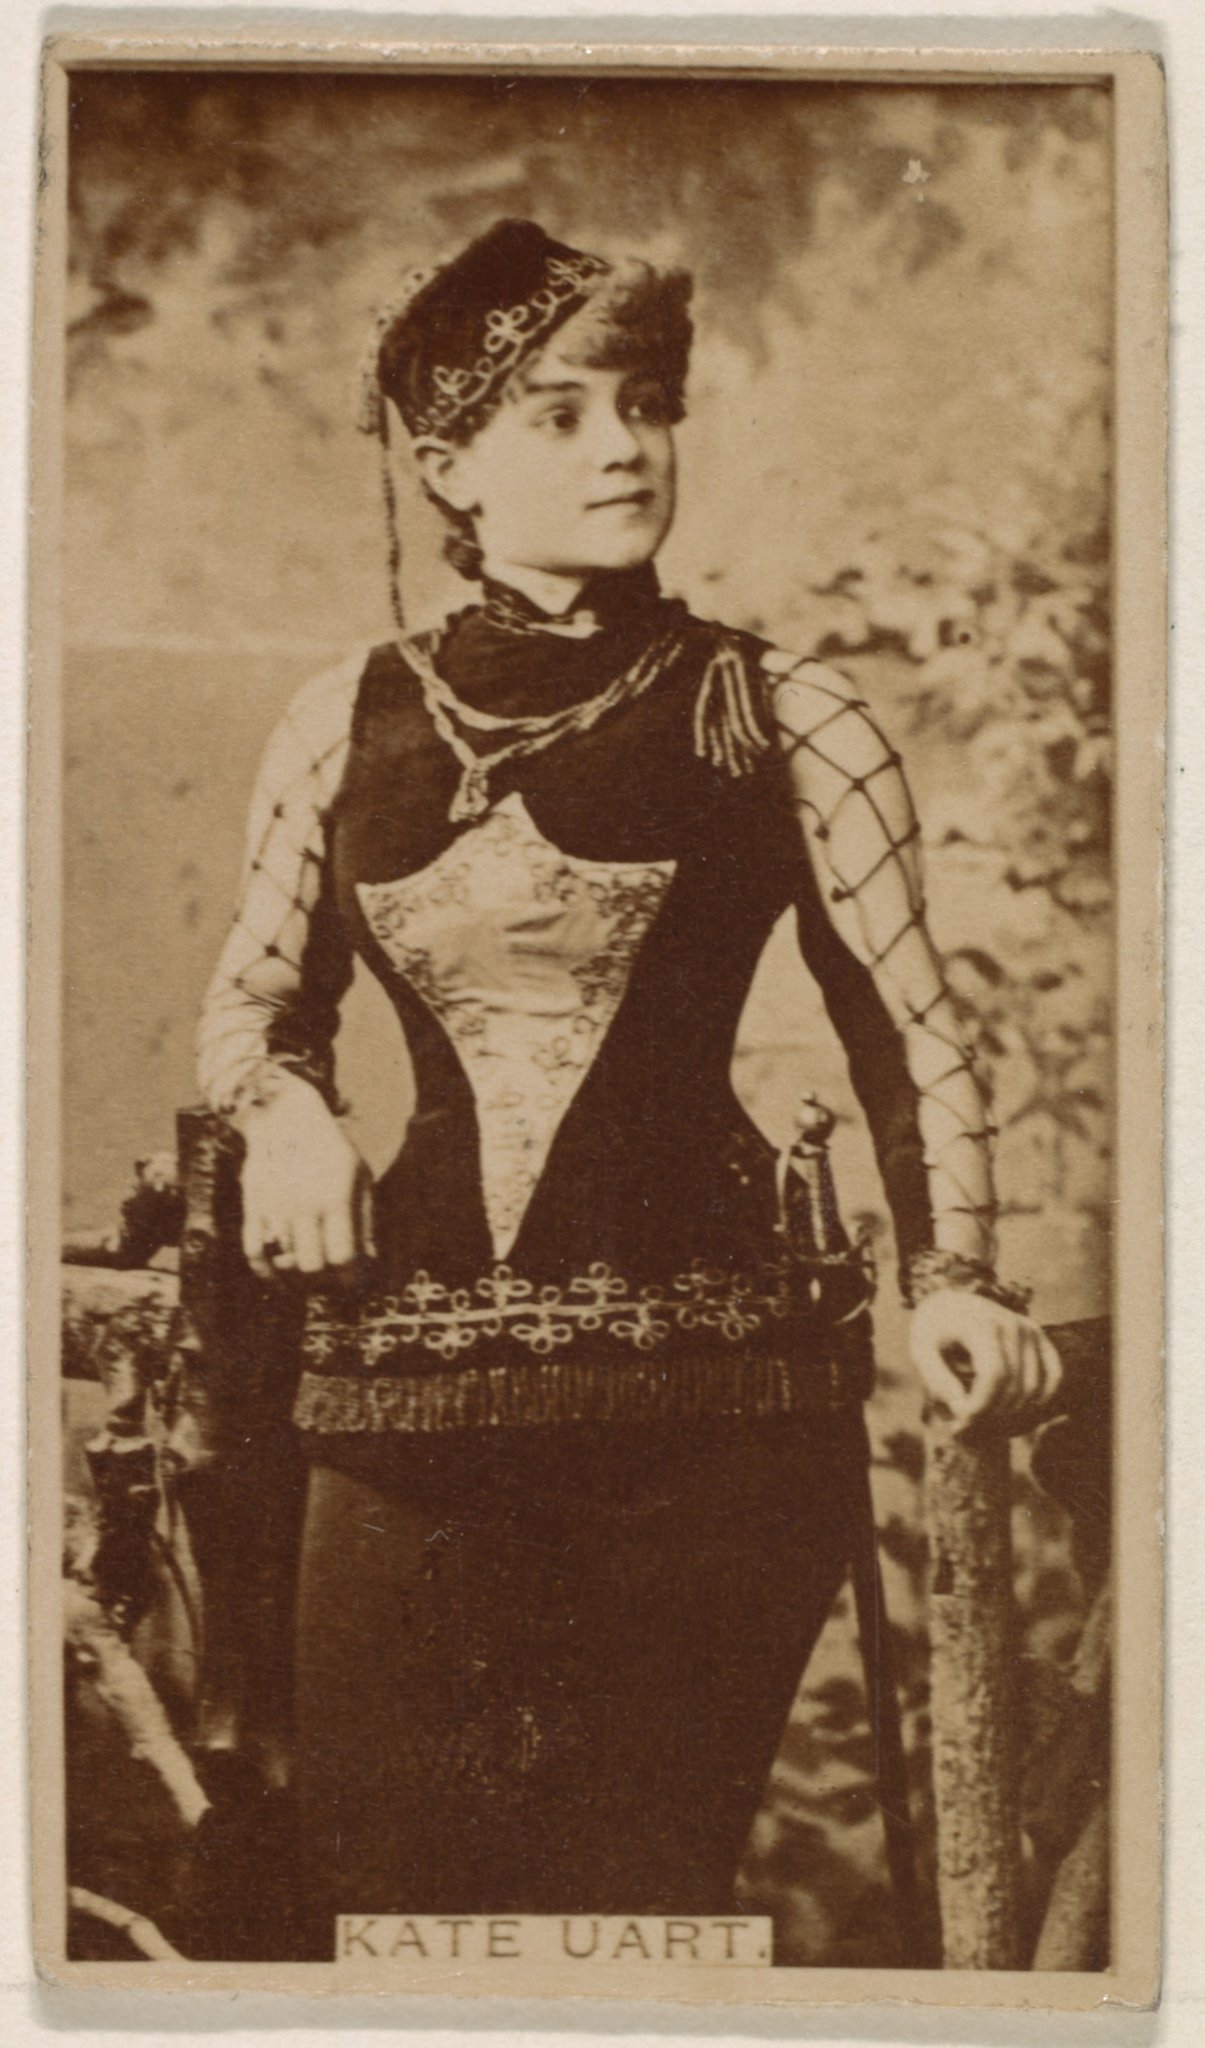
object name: photograph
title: Kate Uart, from the Actresses series (N245) issued by Kinney Brothers to promote Sweet Caporal Cigarettes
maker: kinney brothers tobacco company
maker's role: publisher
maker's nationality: american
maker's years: 1869-2011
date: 1890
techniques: albumen silver print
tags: portraits,women,actresses